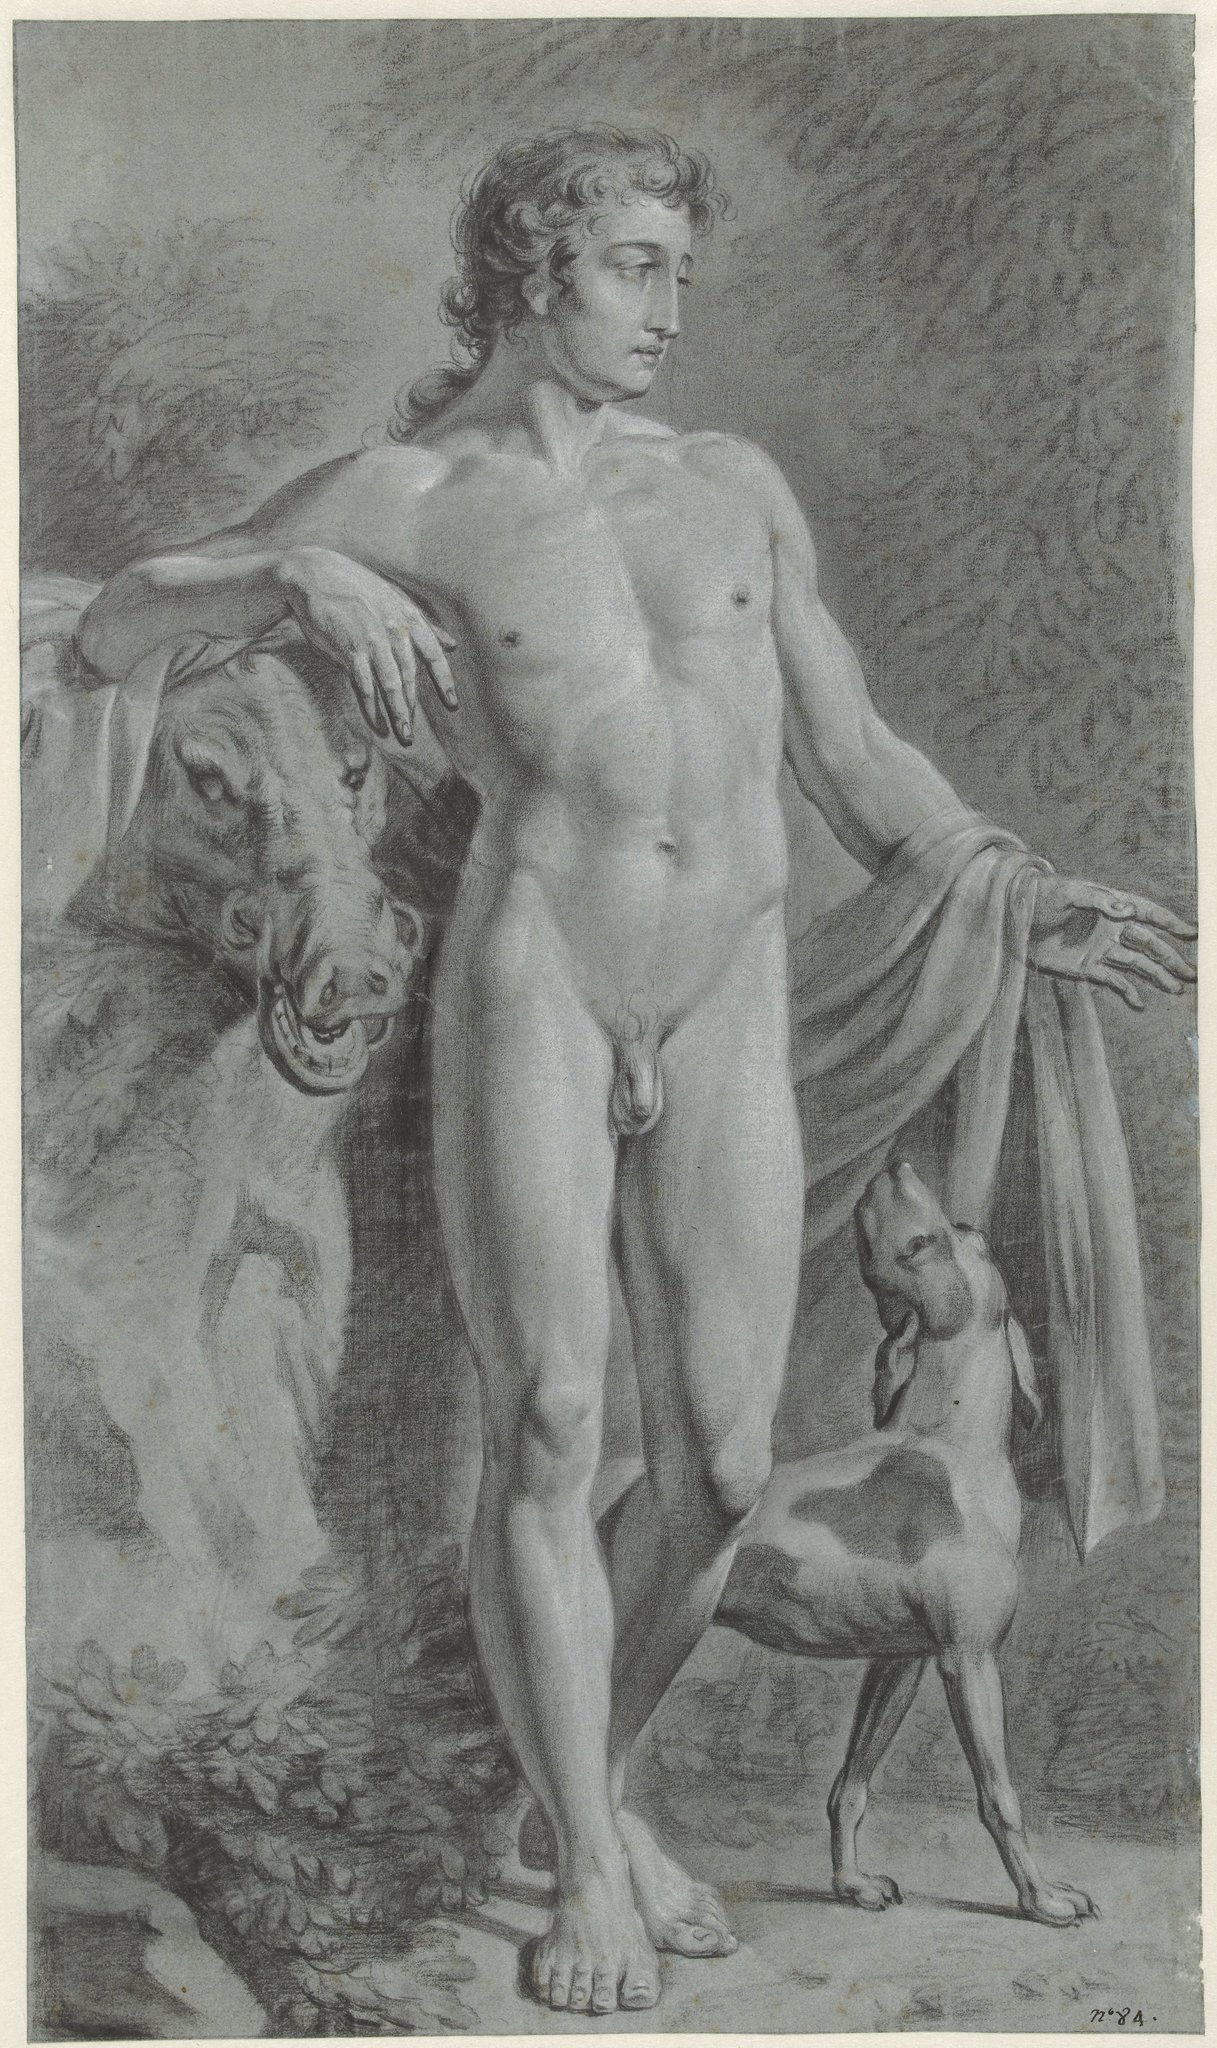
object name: drawing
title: Staand mannelijk naakt met een hond en de kop van een everzwijn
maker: jan kamphuijsen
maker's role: draughtsman, painter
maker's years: 1760-1841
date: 1790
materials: chalk, paper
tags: standing figure, boar (male pig), dog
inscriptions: date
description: Staand mannelijk naakt met een hond en de kop van een everzwijn. Nr. 84.